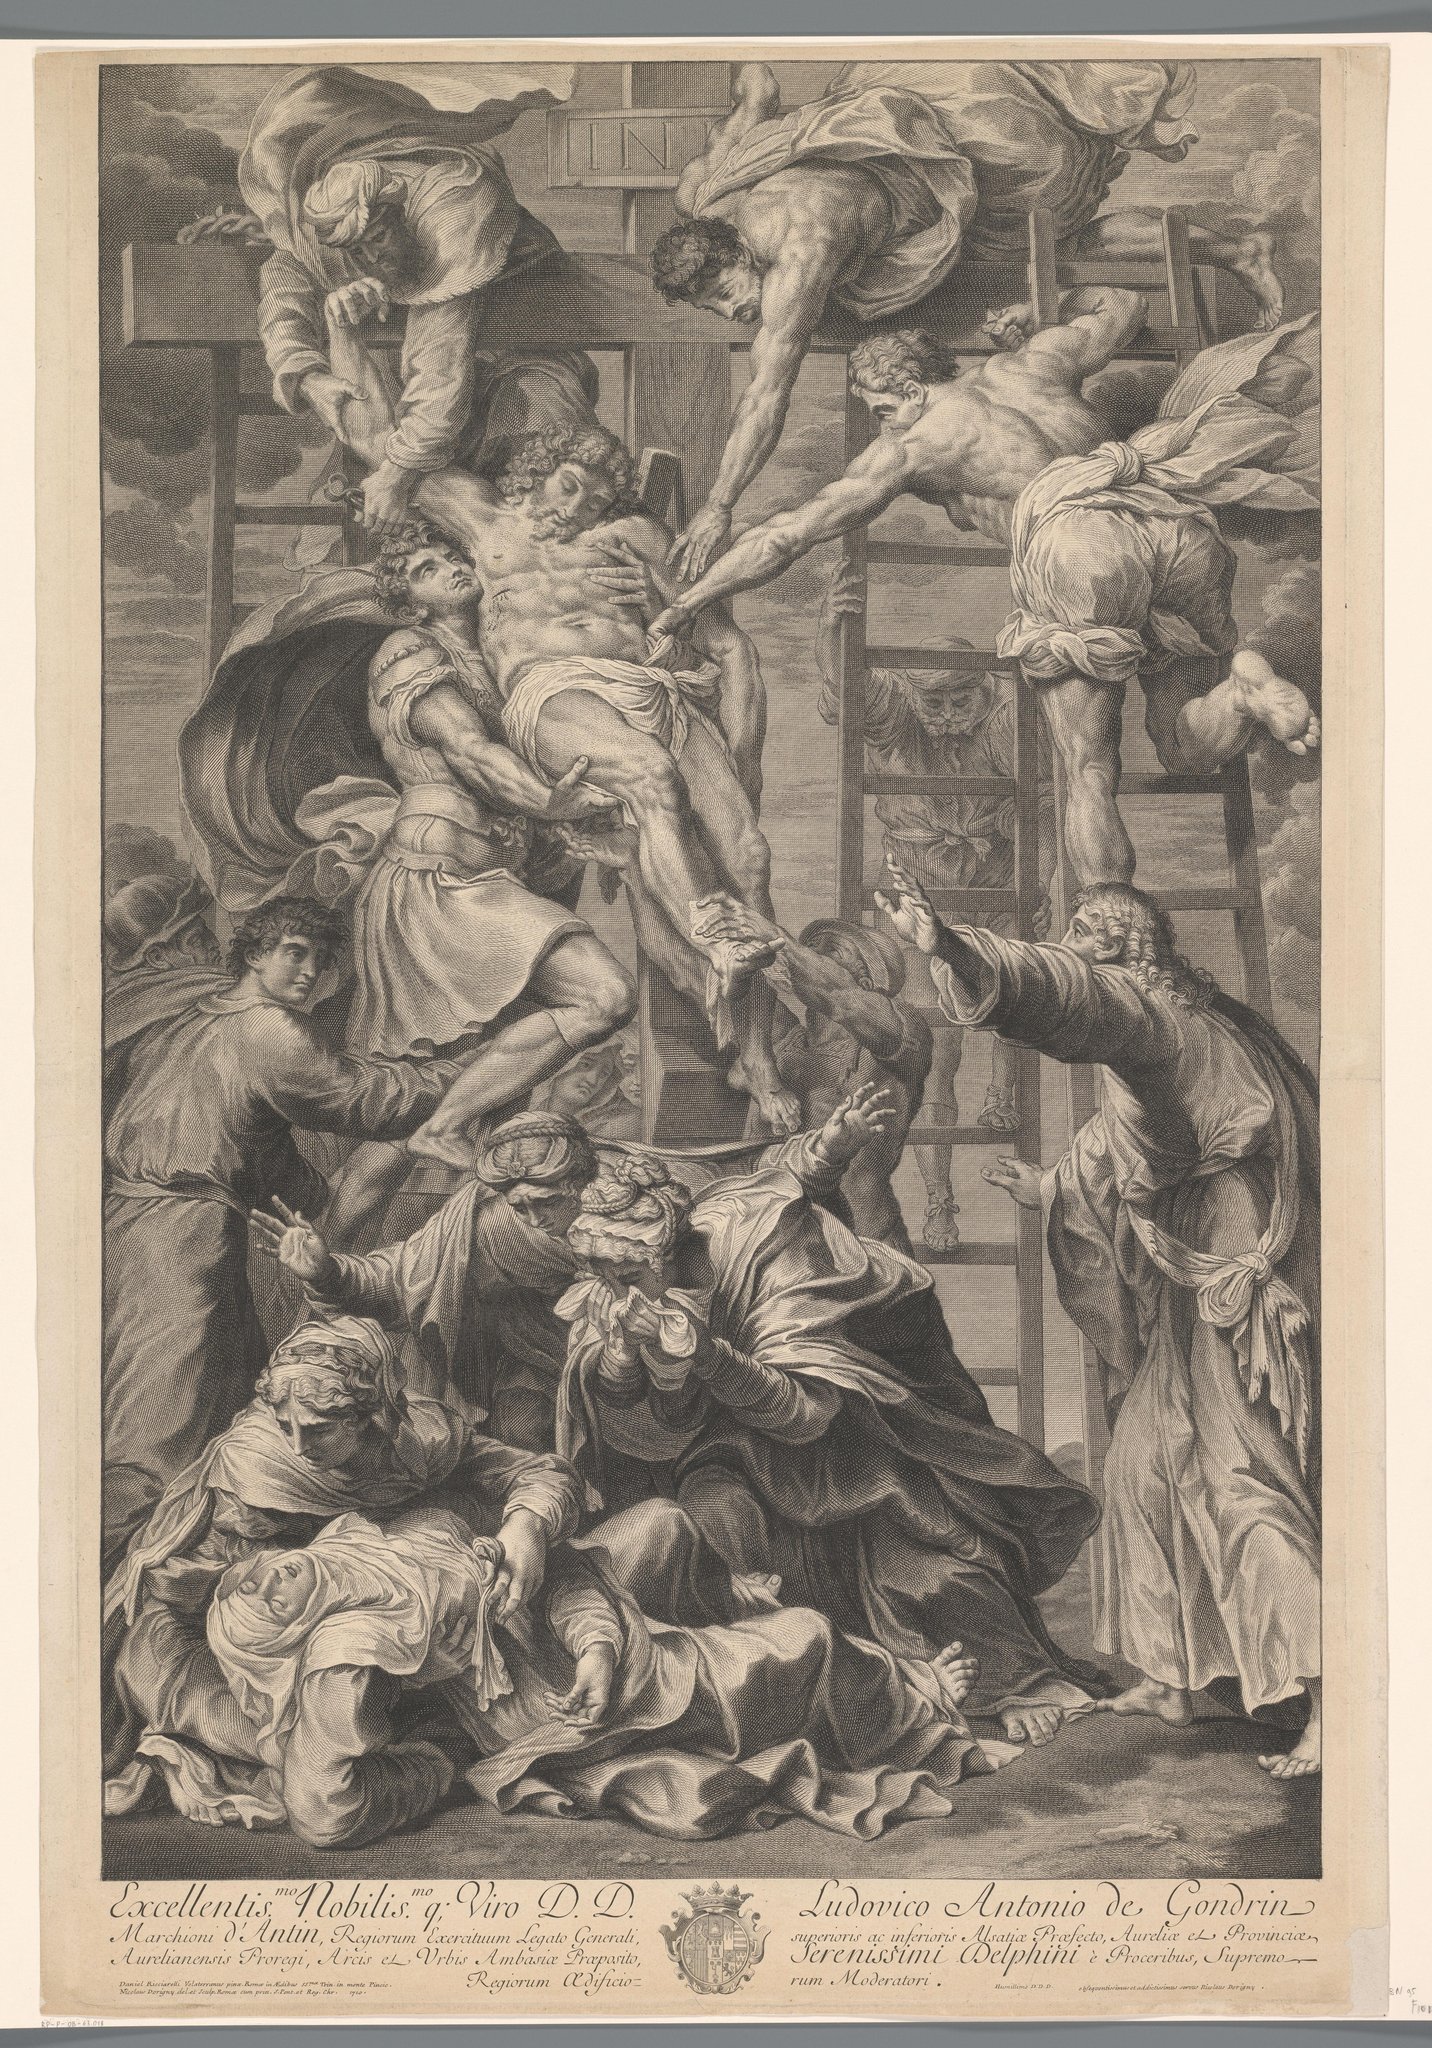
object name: print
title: Kruisafname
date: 1710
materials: paper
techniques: engraving, etching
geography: rome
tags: from christ's deposition to his entombment (matthew 27:58-66; mark 15:46-47; luke 23:53-56; john 19:39-42)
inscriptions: watermark, collector's mark: Lugt 2228